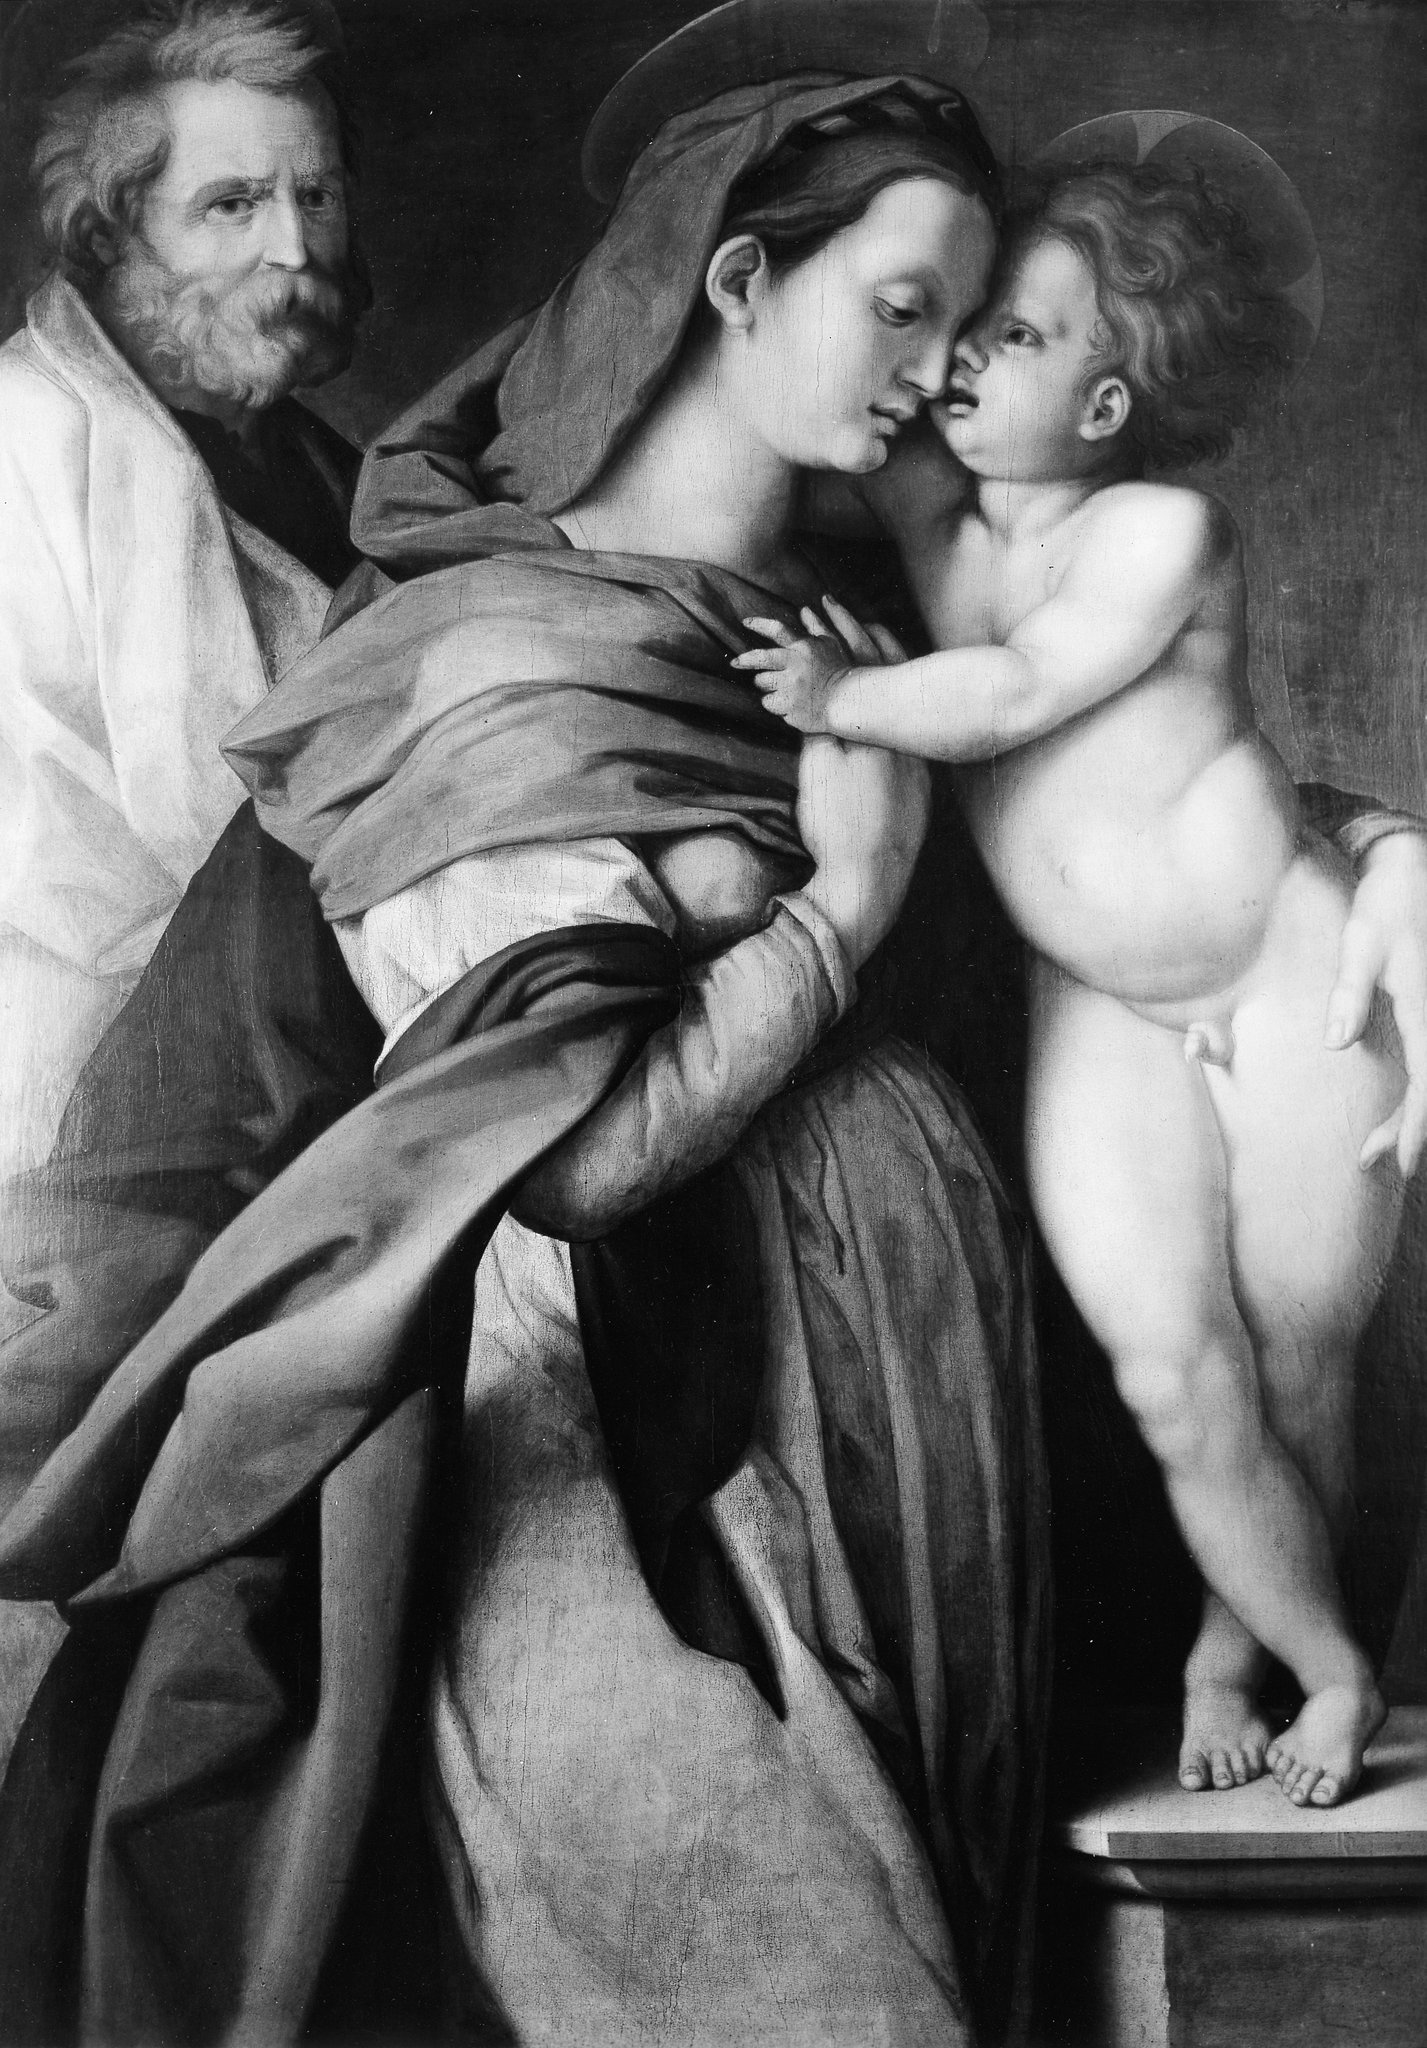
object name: painting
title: Holy Family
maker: jacopino del conte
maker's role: artist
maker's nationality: italian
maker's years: 1515-1598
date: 1535-1598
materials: oil, wood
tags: christ,holy family,saint joseph,virgin mary